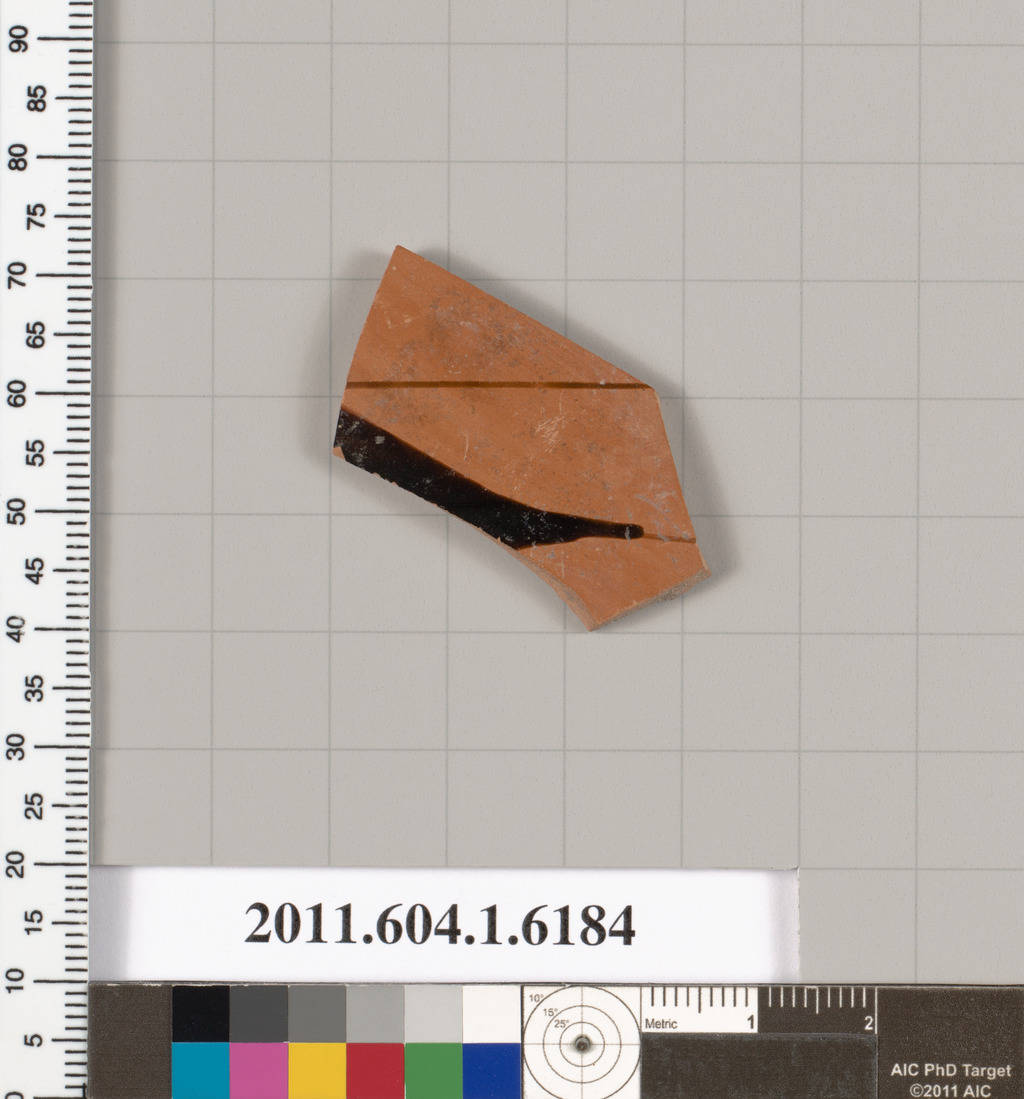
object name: kylix fragment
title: Terracotta fragment of a kylix (drinking cup)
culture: greek, attic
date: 520-500 BCE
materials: terracotta